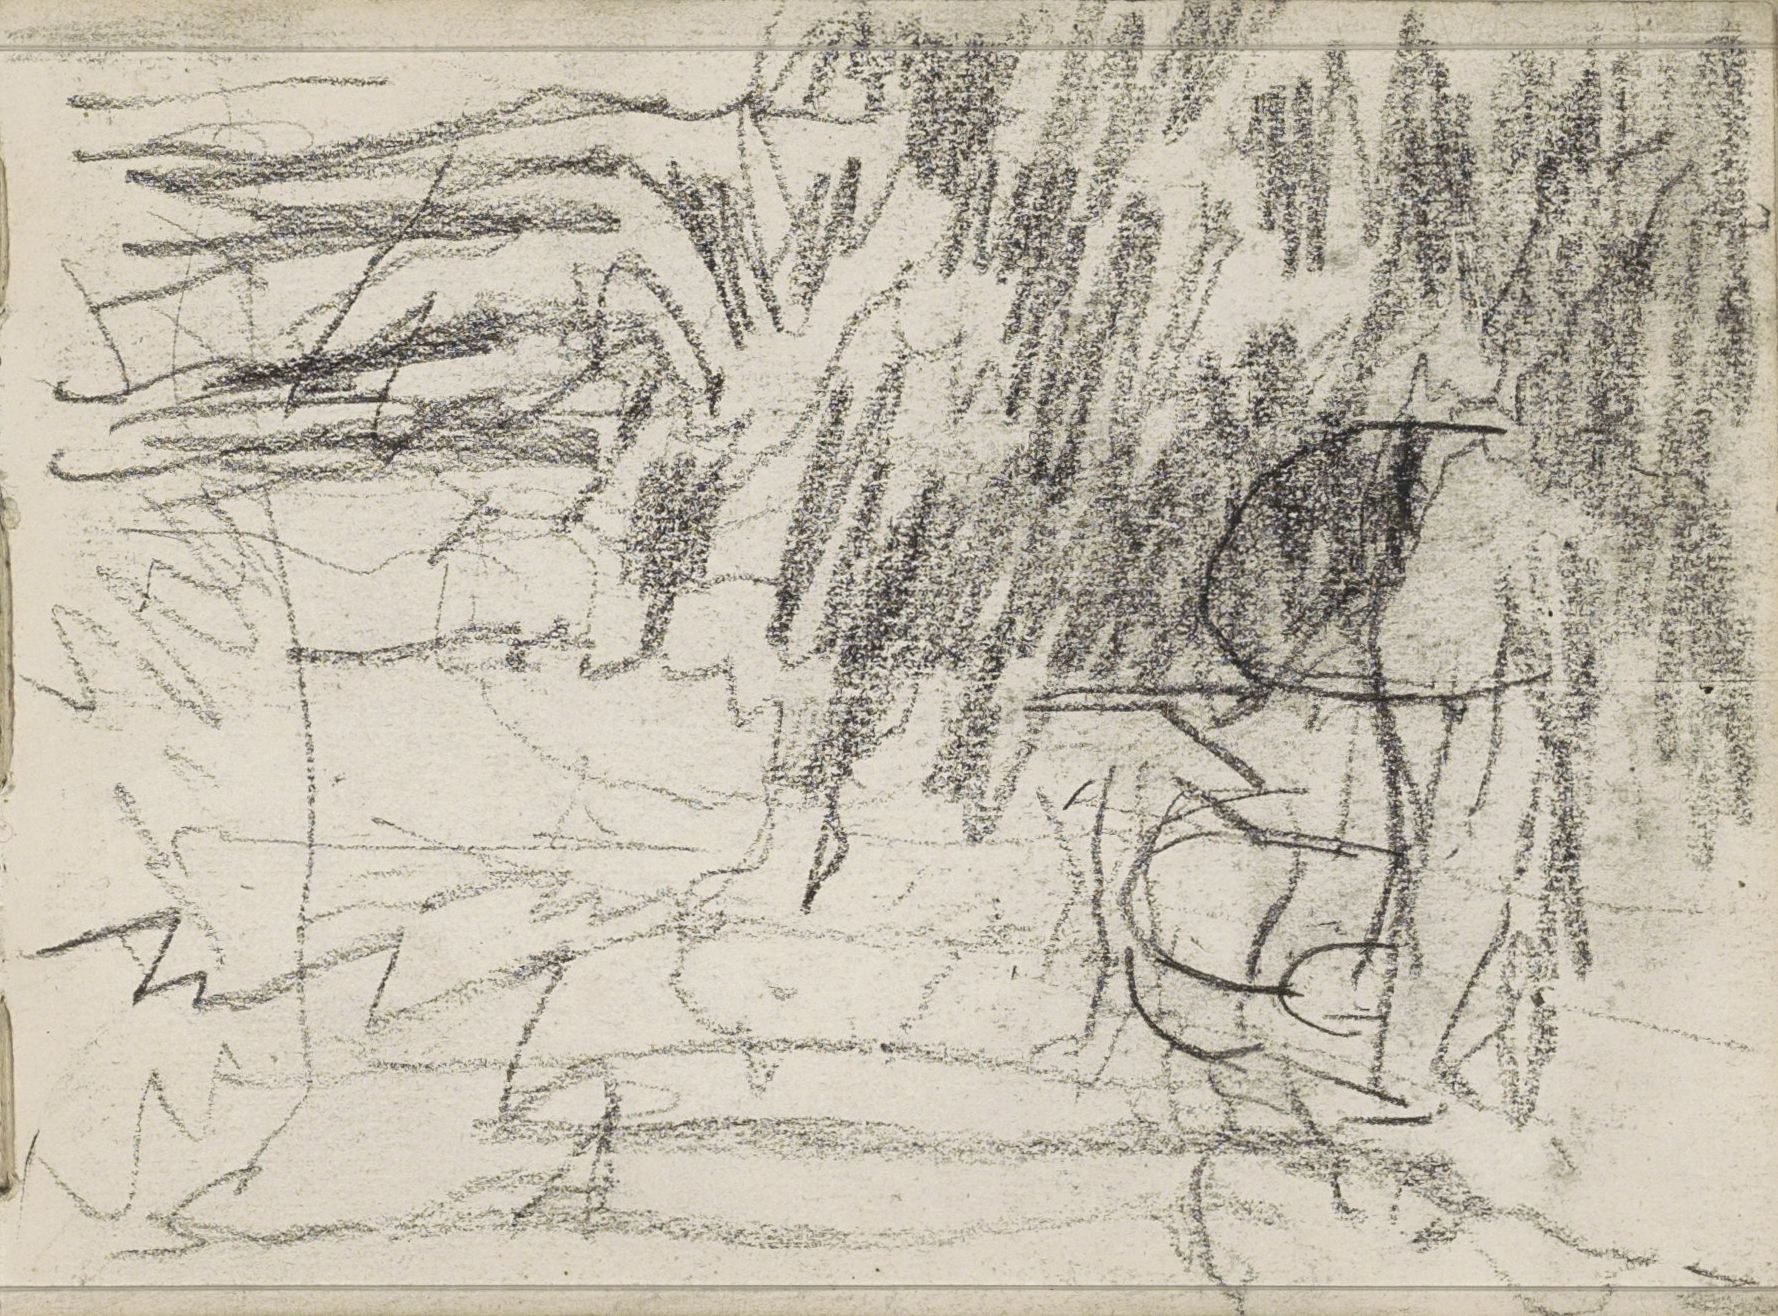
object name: sketchbook leaf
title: Studie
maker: anton mauve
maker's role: draughtsman, painter, print maker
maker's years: 1838-1888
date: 1848-1888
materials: chalk, paper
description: Blad 23 recto uit een schetsboek met 33 bladen.